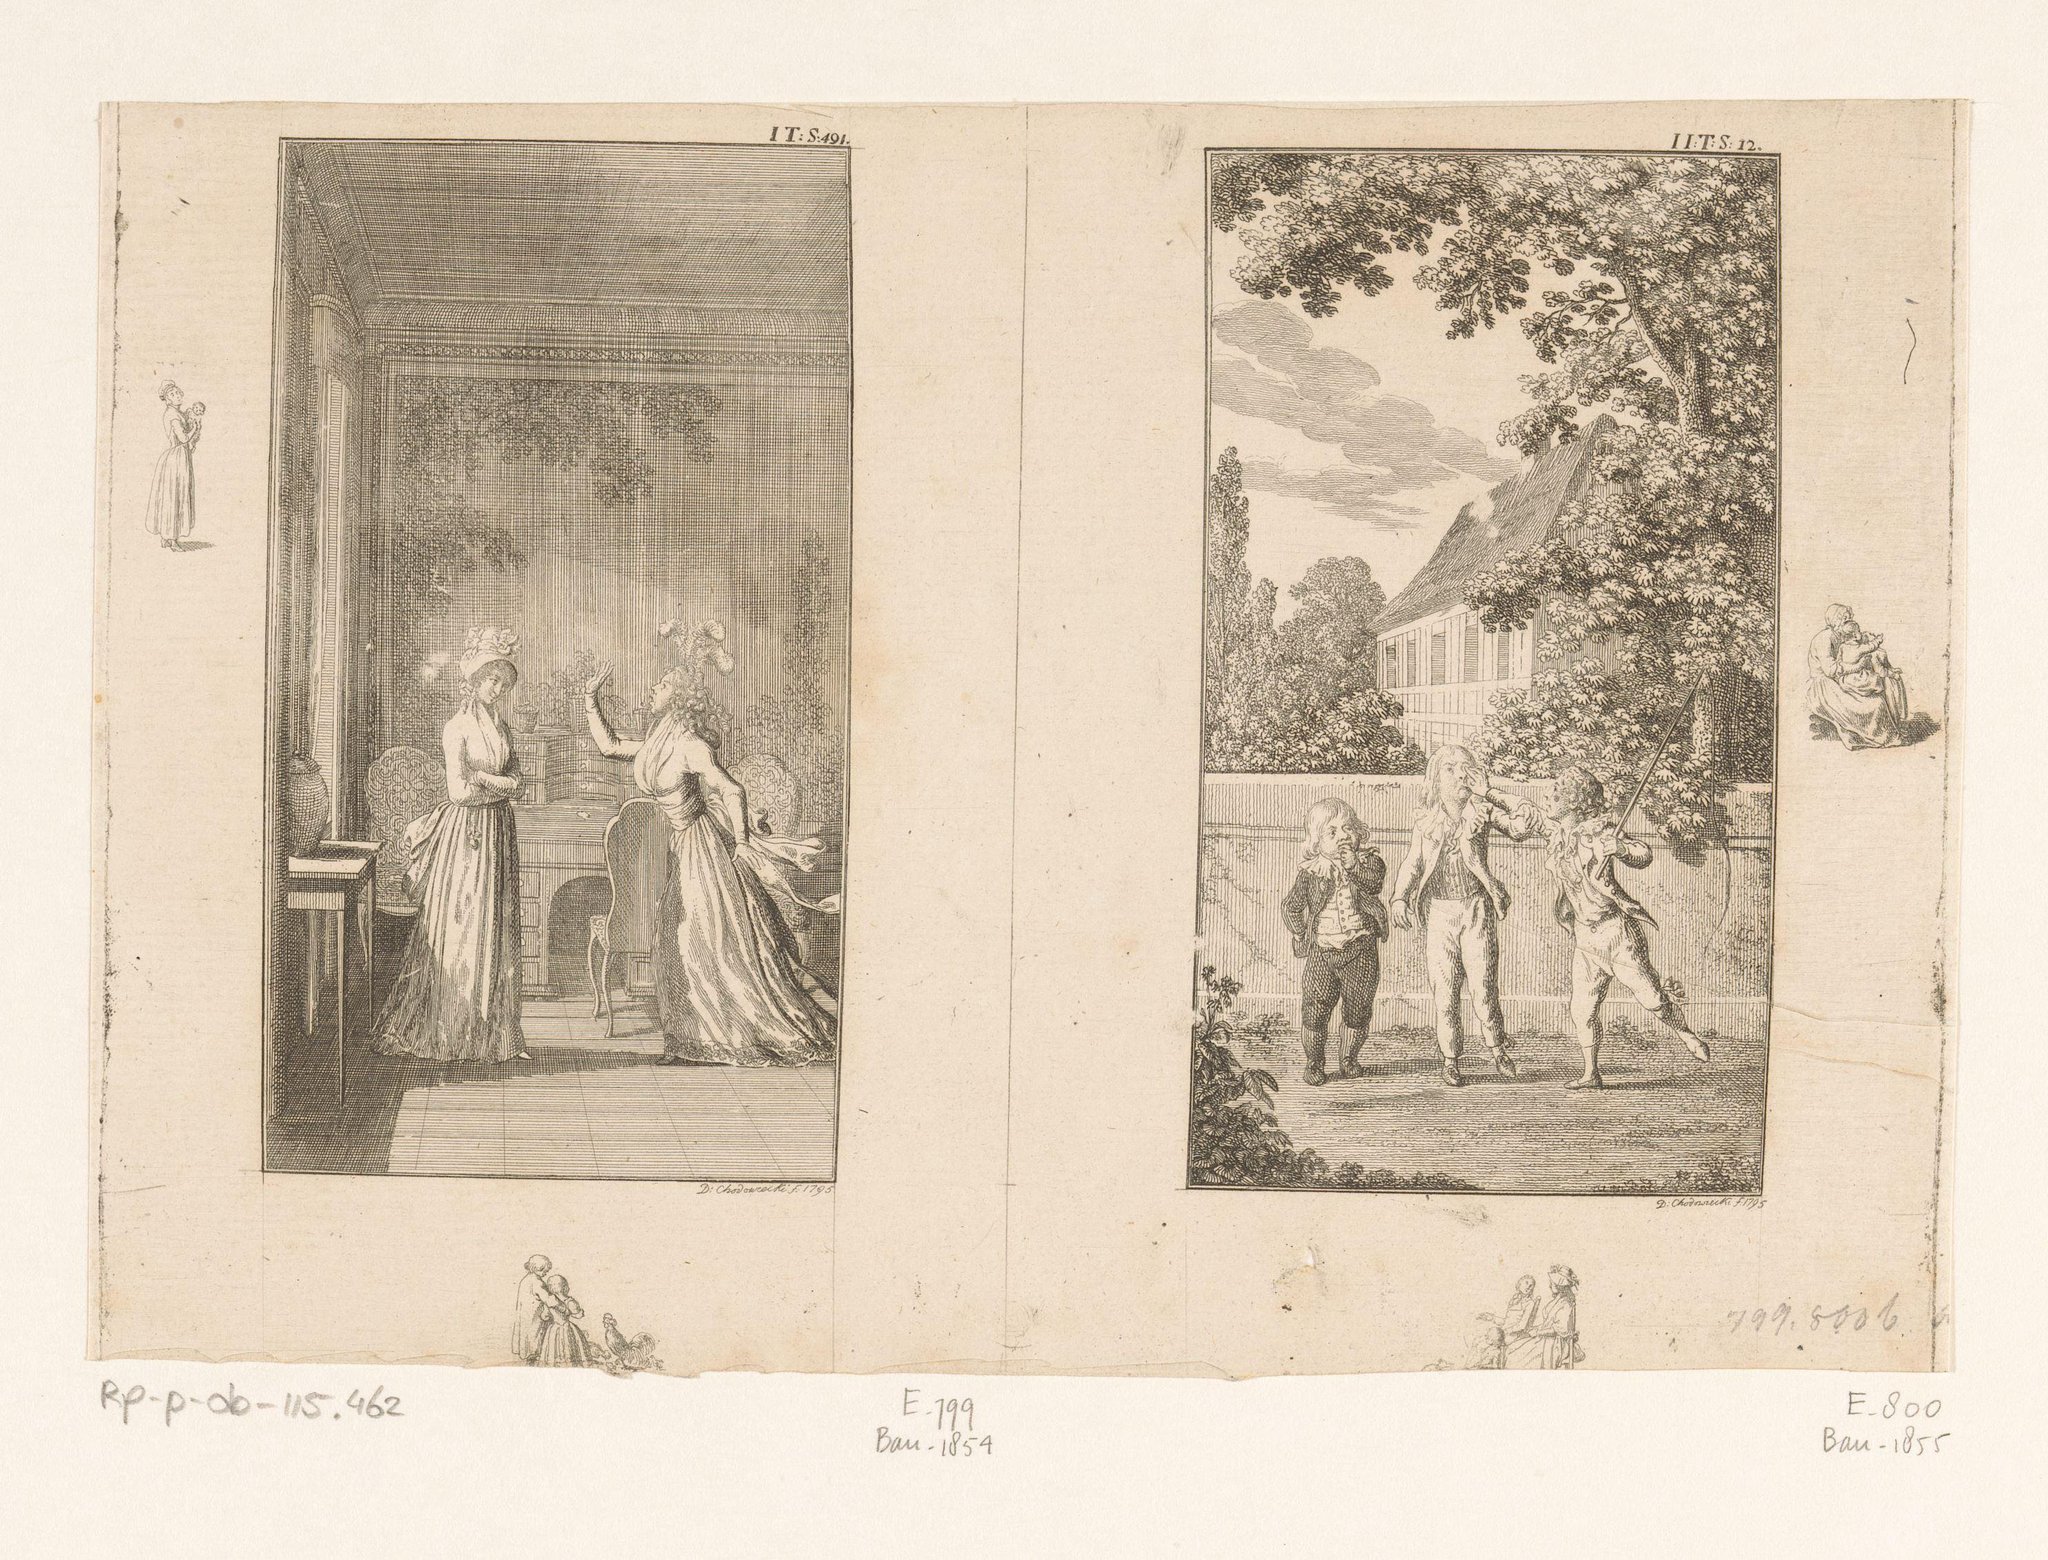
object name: print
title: Twee voorstellingen uit Clarissa van Samuel Richardson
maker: daniel nikolaus chodowiecki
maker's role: draughtsman, print maker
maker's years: 1726-1801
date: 1795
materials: paper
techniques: etching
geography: berlin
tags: adolescent, young woman, maiden, literature, child, quarrel, argument, whip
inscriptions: collector's mark: Lugt 2228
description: Latere staat gebruikt voor: Richardson, Samuel. Clarissens Schicksale dargestellt in vier und zwanzig Kupferblättern von Daniel Chodowiecki. mit Erläuterungen des Deutschen Uebersetzers Dr. L. Th. Kosegarten. Leipzig: Heinrich Gräff, 1796.